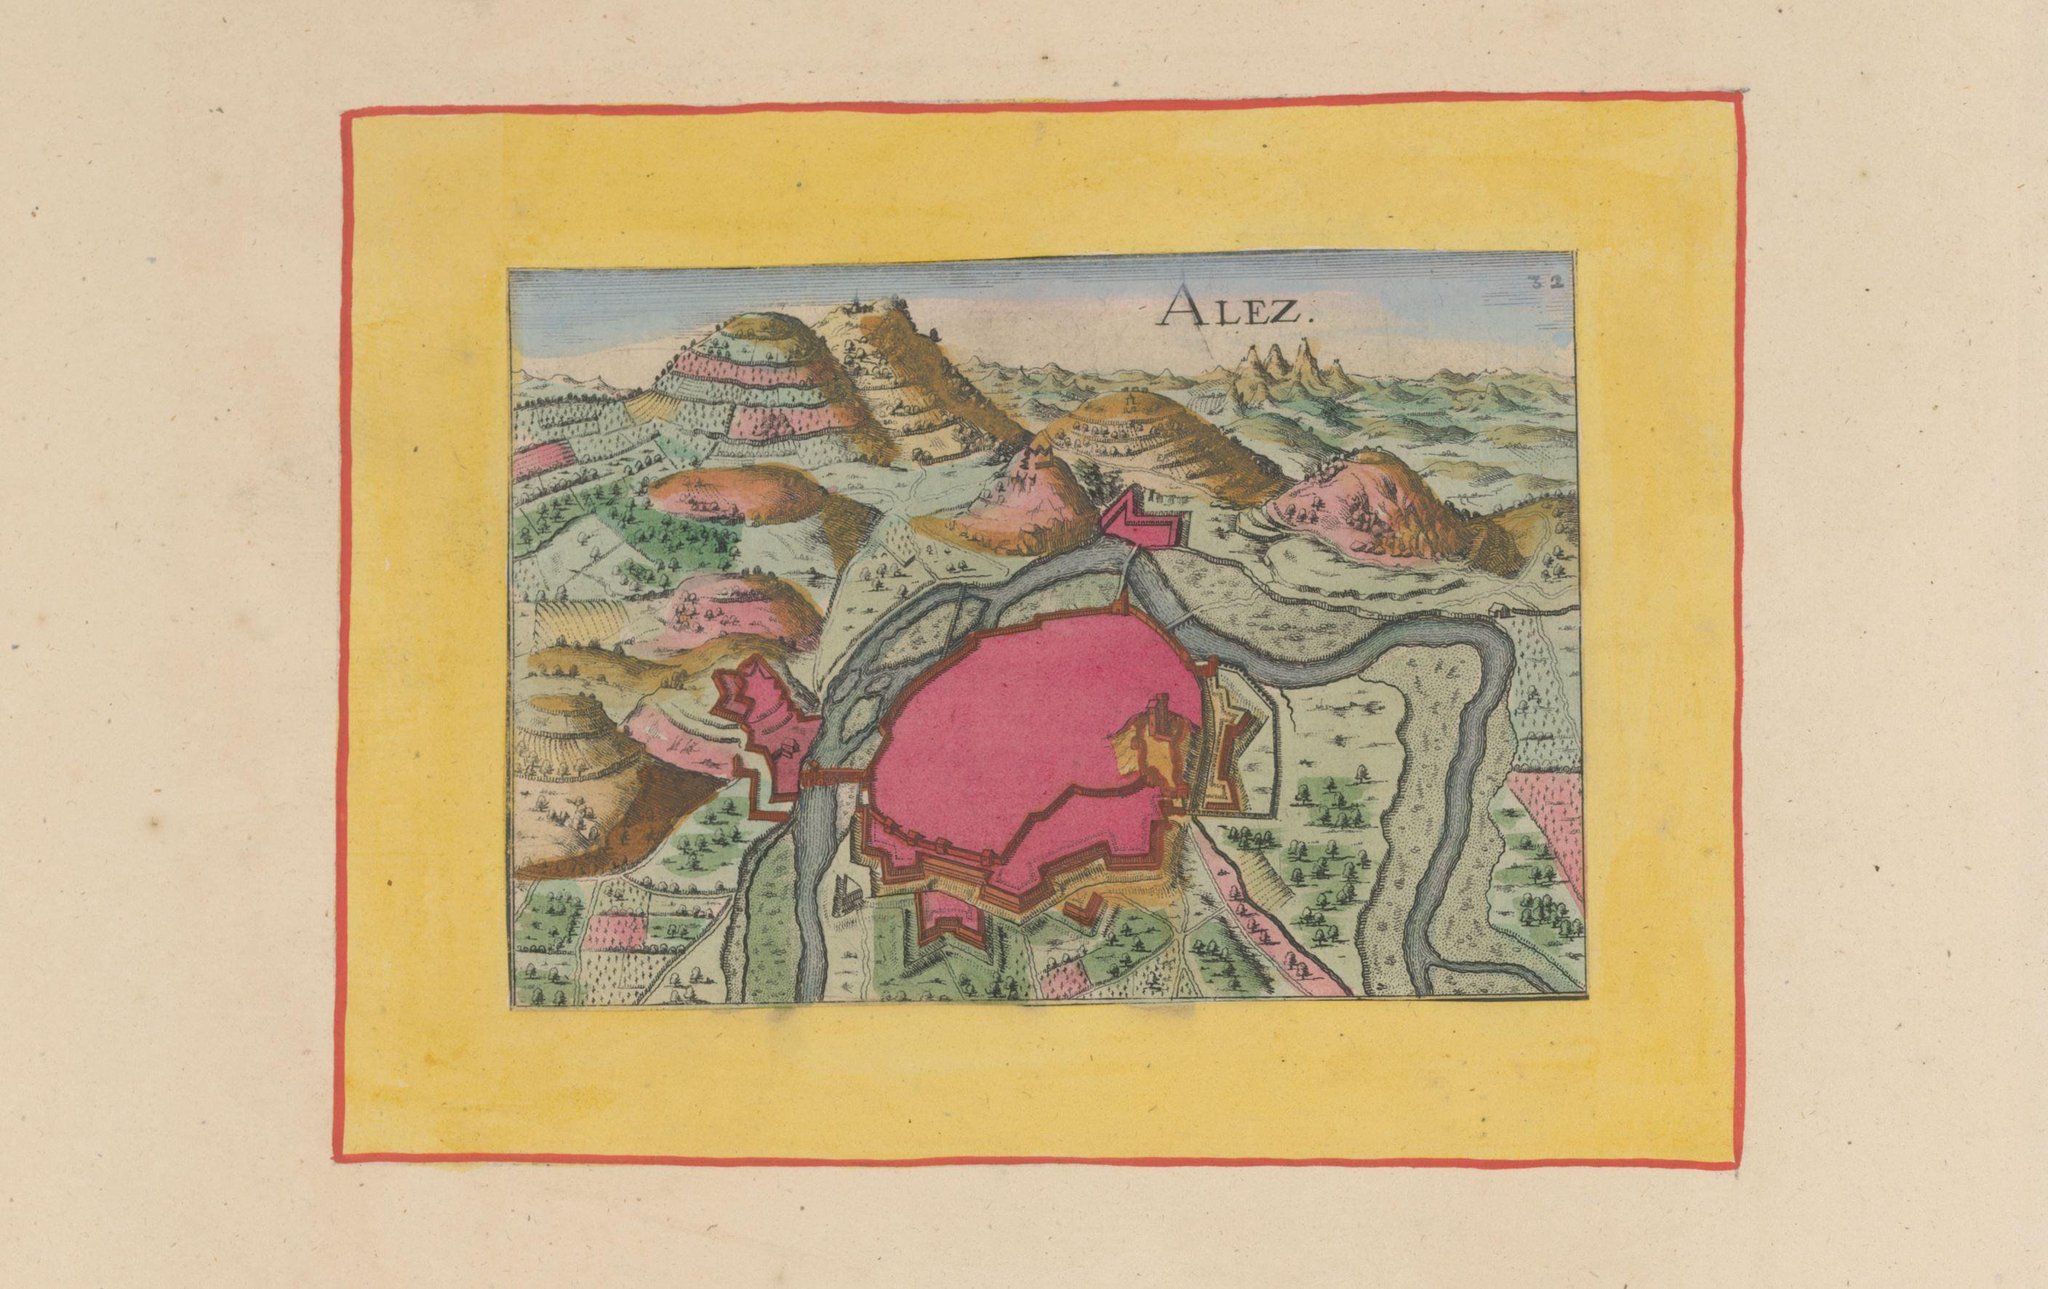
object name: print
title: Alez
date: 1638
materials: paper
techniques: engraving, etching, hand coloring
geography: paris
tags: maps of cities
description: Prent uit: Tassin, Christophe. Les plans et profils de toutes les principales villes et lieux considérables de France (...). Parijs: Michel van Lochom, 1638, prent nummer 32 in het deel 'Languedoc'.